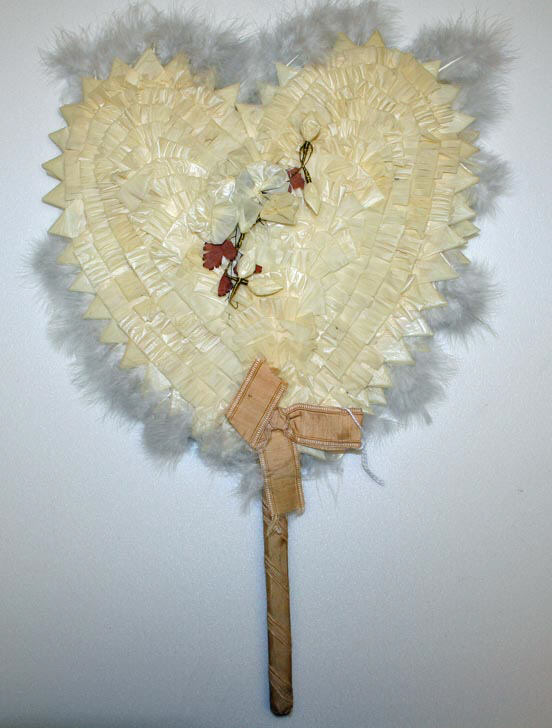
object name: fan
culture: american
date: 1895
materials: feather, paper